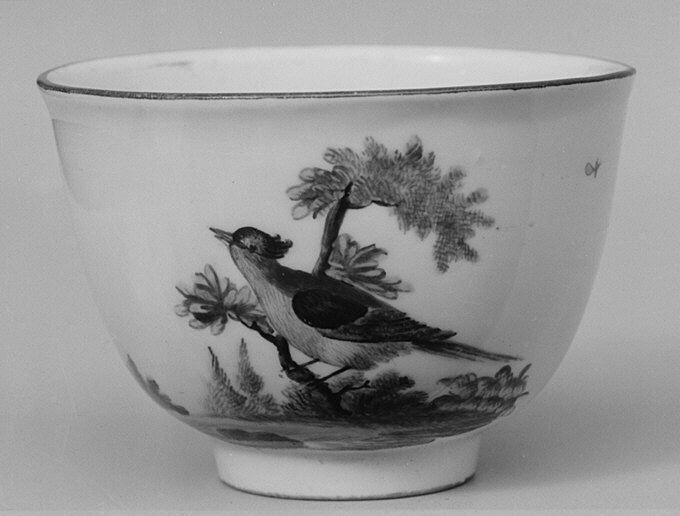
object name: cup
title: Cup (part of a service)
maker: frankenthal porcelain manufactory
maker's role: manufactory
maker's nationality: german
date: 1770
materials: hard paste porcelain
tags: birds,trees